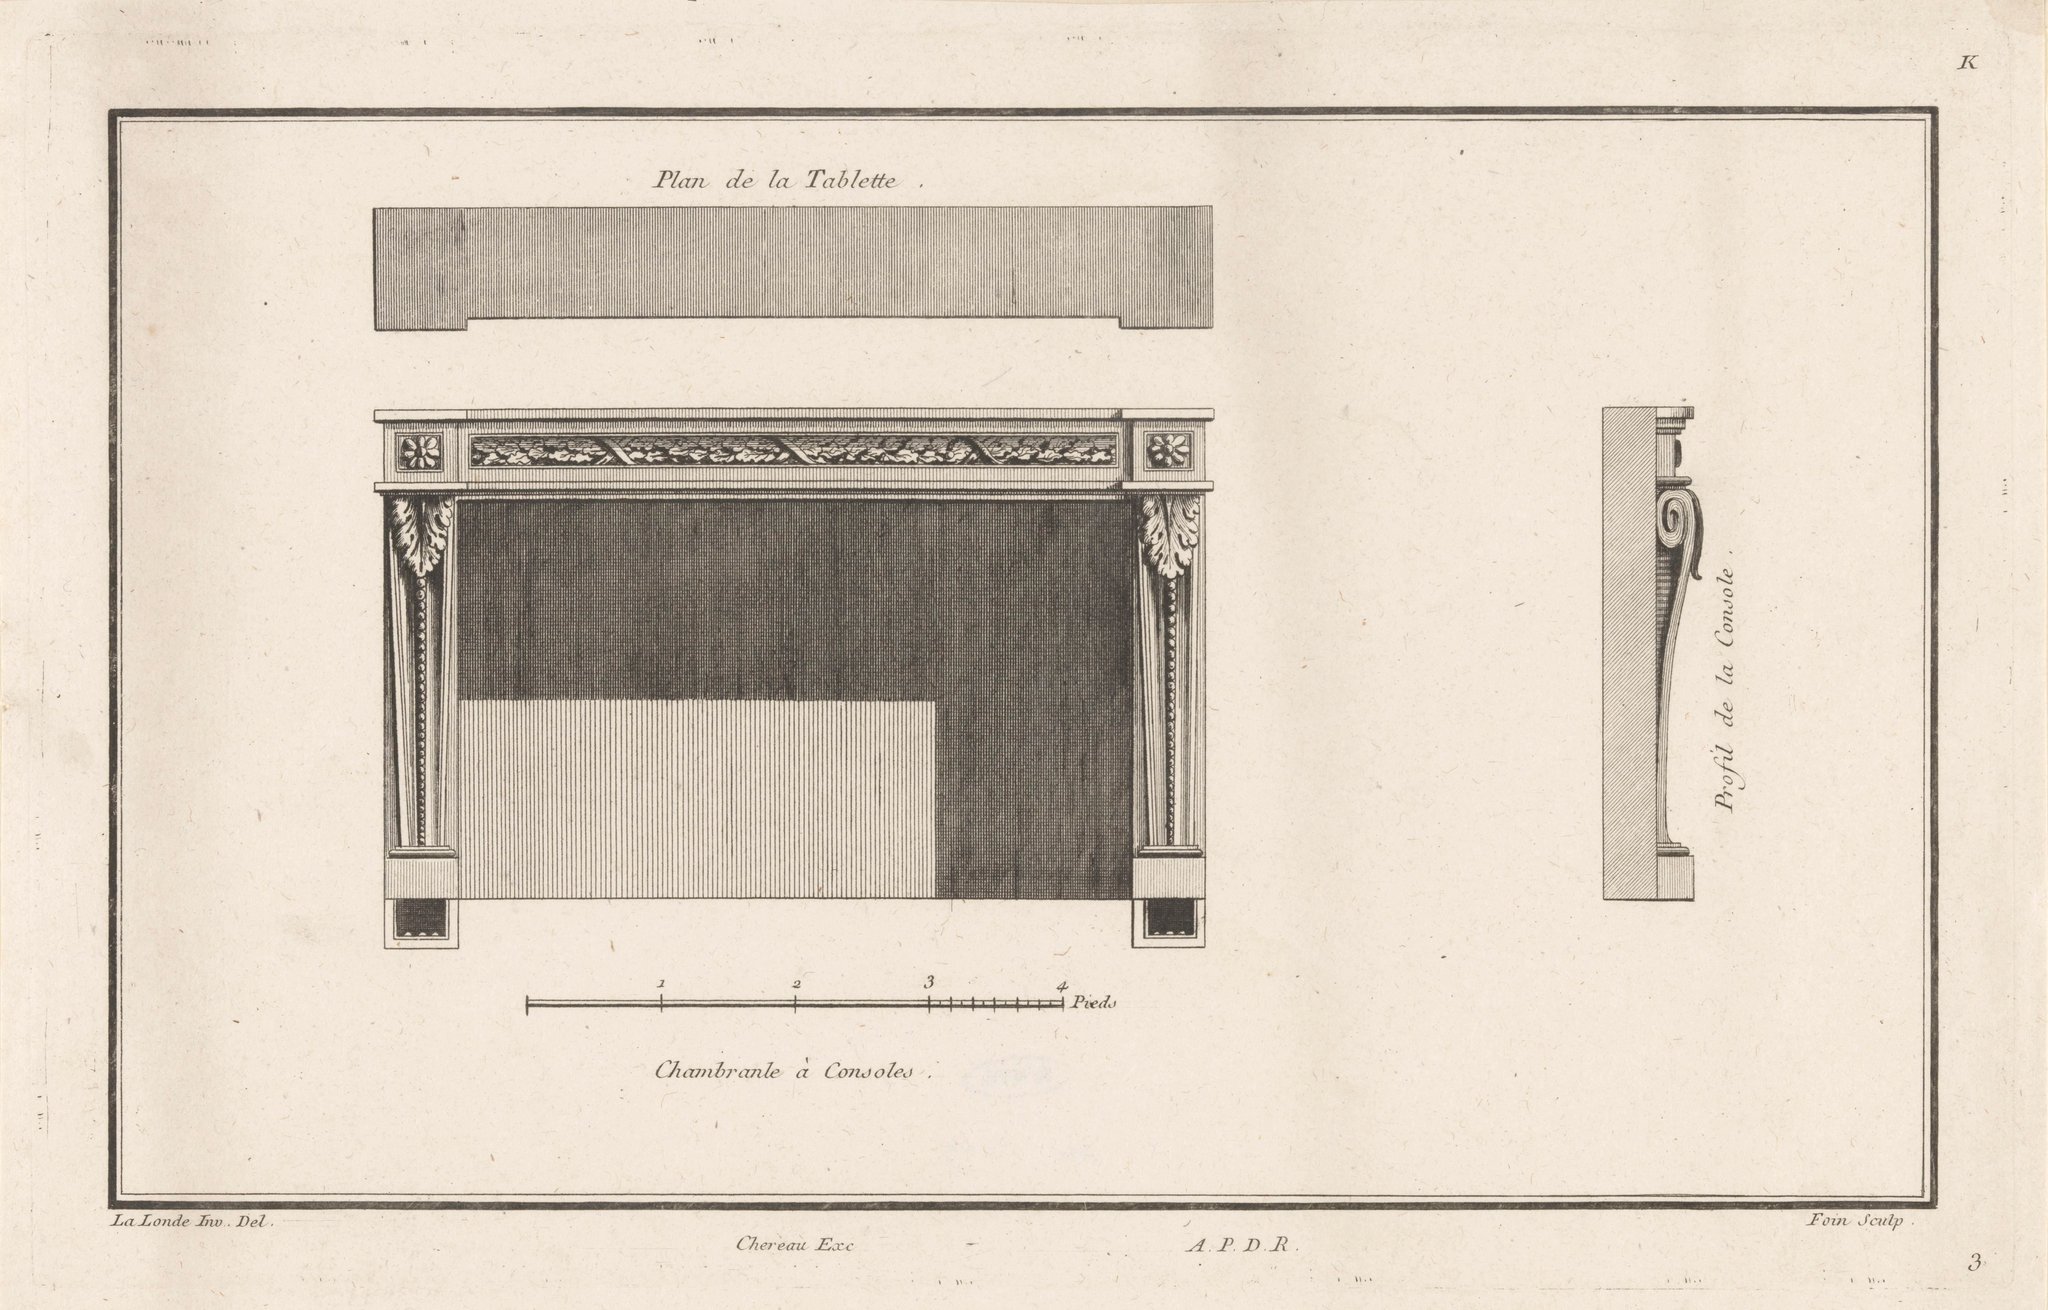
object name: ornament print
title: K Chambranles de Cheminées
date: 1784-1785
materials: paper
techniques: engraving, etching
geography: paris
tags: other architectural details (console), open hearth, fire-place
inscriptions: collector's mark: Lugt 2760, collector's mark: Lugt 2228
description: Voor-, zij- en bovenaanzicht van een geornamenteerde haard met consoles met acanthusbladeren.